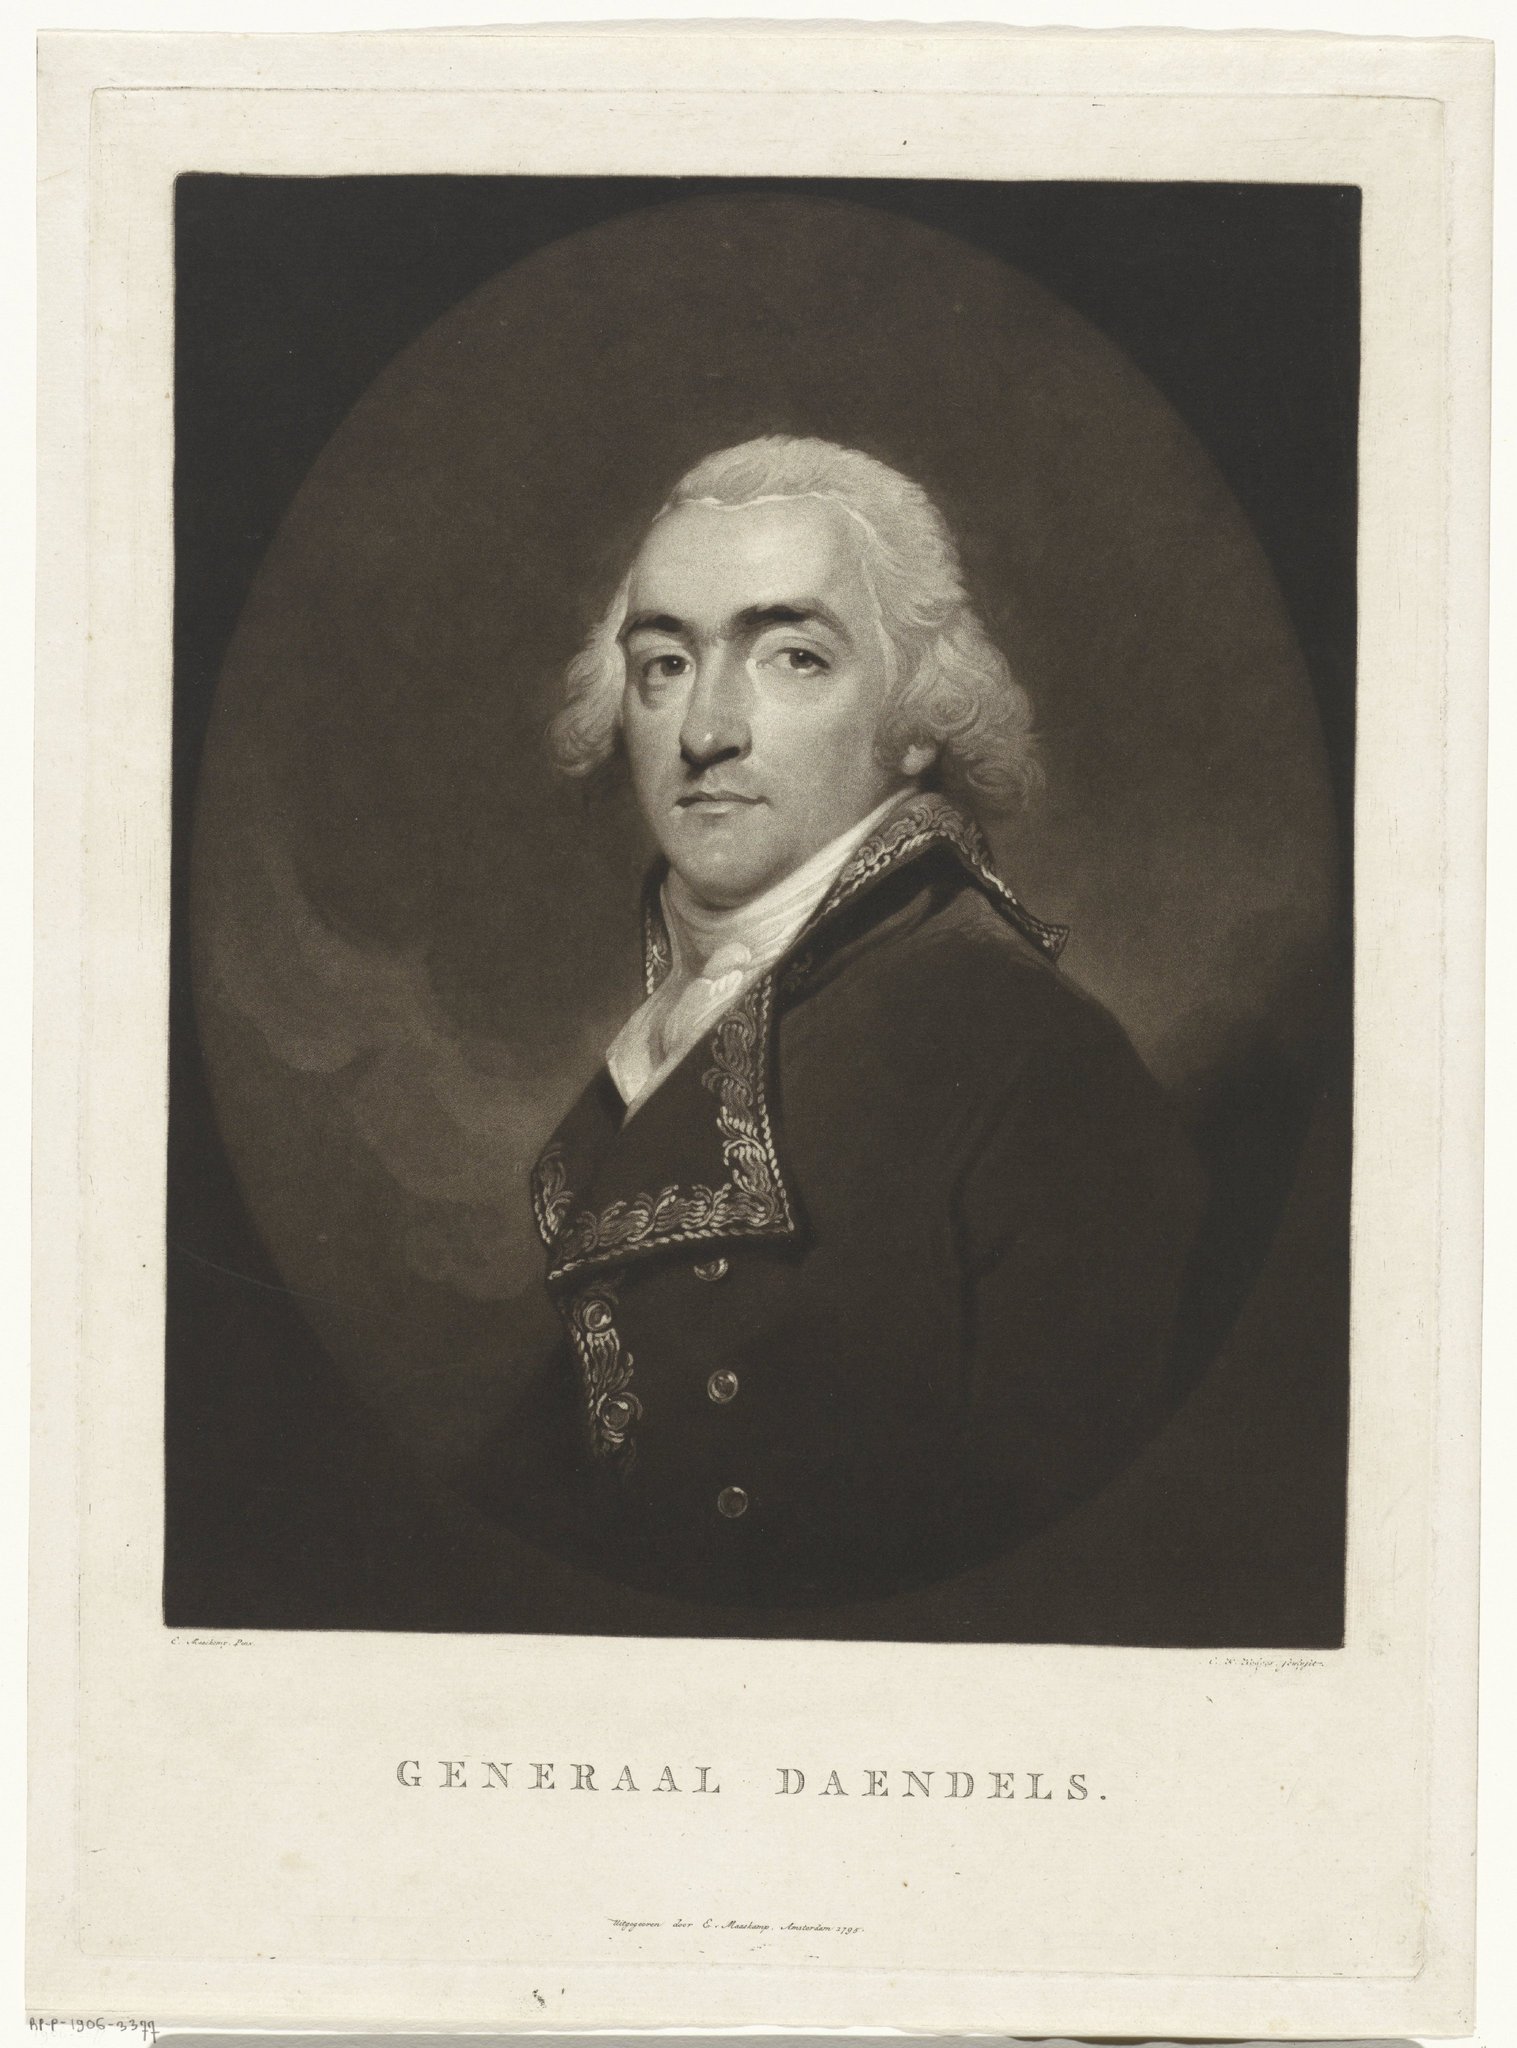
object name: print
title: Portret van Herman Willem Daendels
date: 1795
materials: paper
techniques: engraving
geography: amsterdam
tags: herman willem daendels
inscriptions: collector's mark: Lugt 2228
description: Portretbuste van de generaal Herman Willem Daendels, in militair uniform.